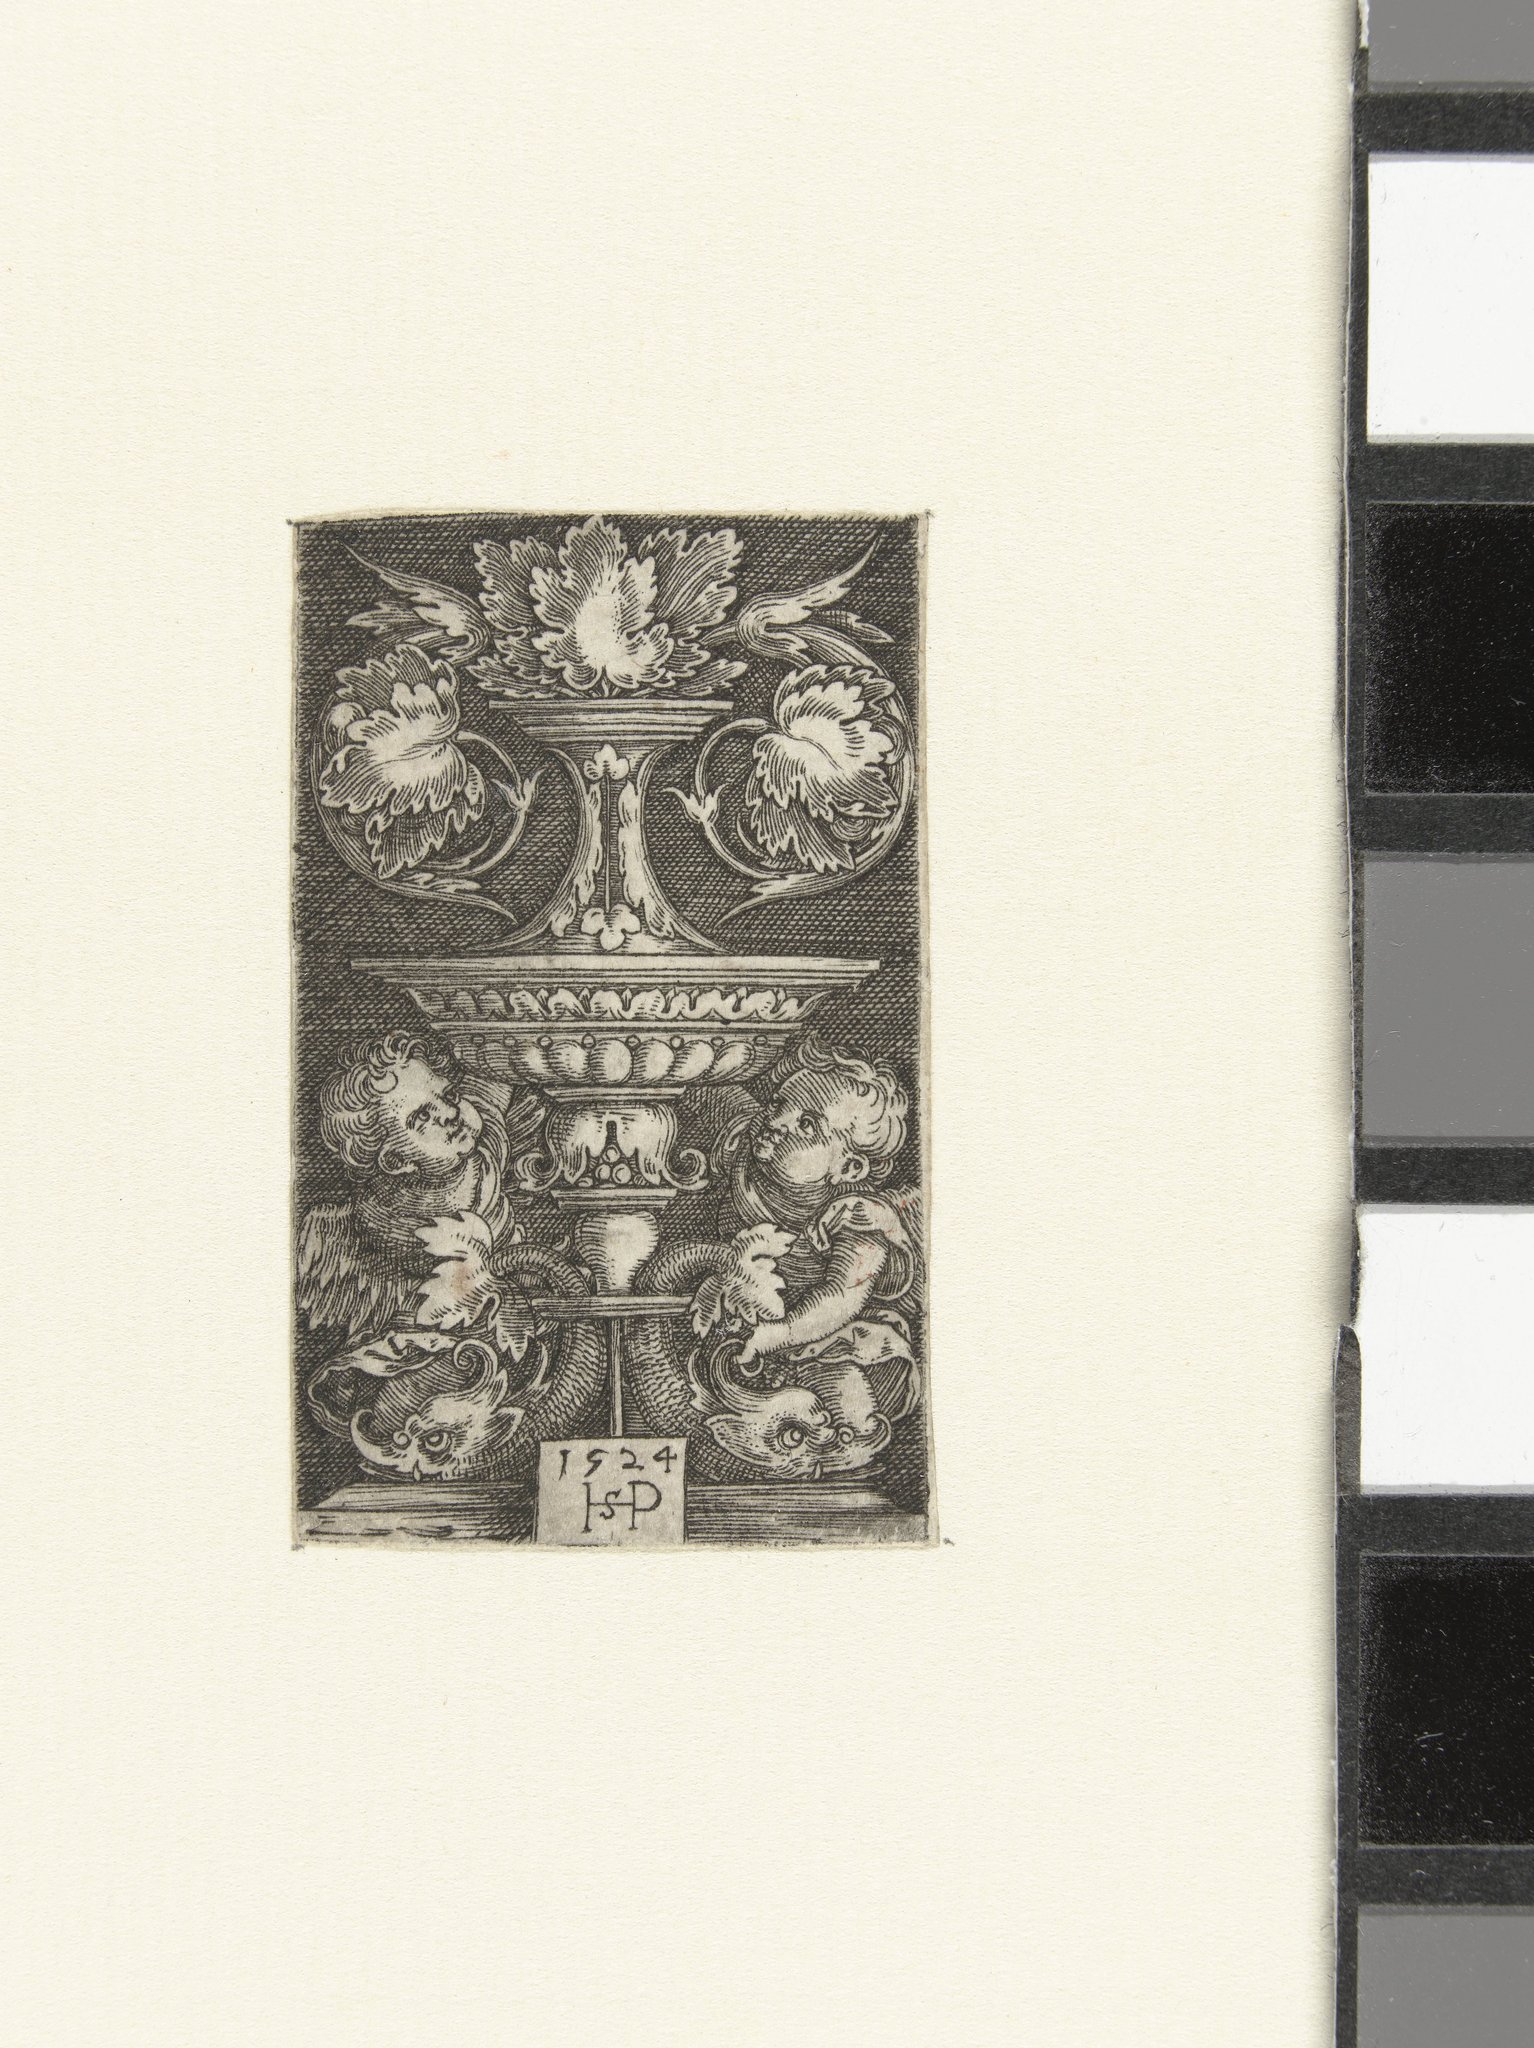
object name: ornament print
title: Vaas met bladranken, rustend op twee dolfijnen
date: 1510-1524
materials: paper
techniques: engraving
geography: germany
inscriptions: collector's mark: Lugt 240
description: Vlakdecoratie. Achter elke dolfijn staat een putto. Gearceerde achtergrond.